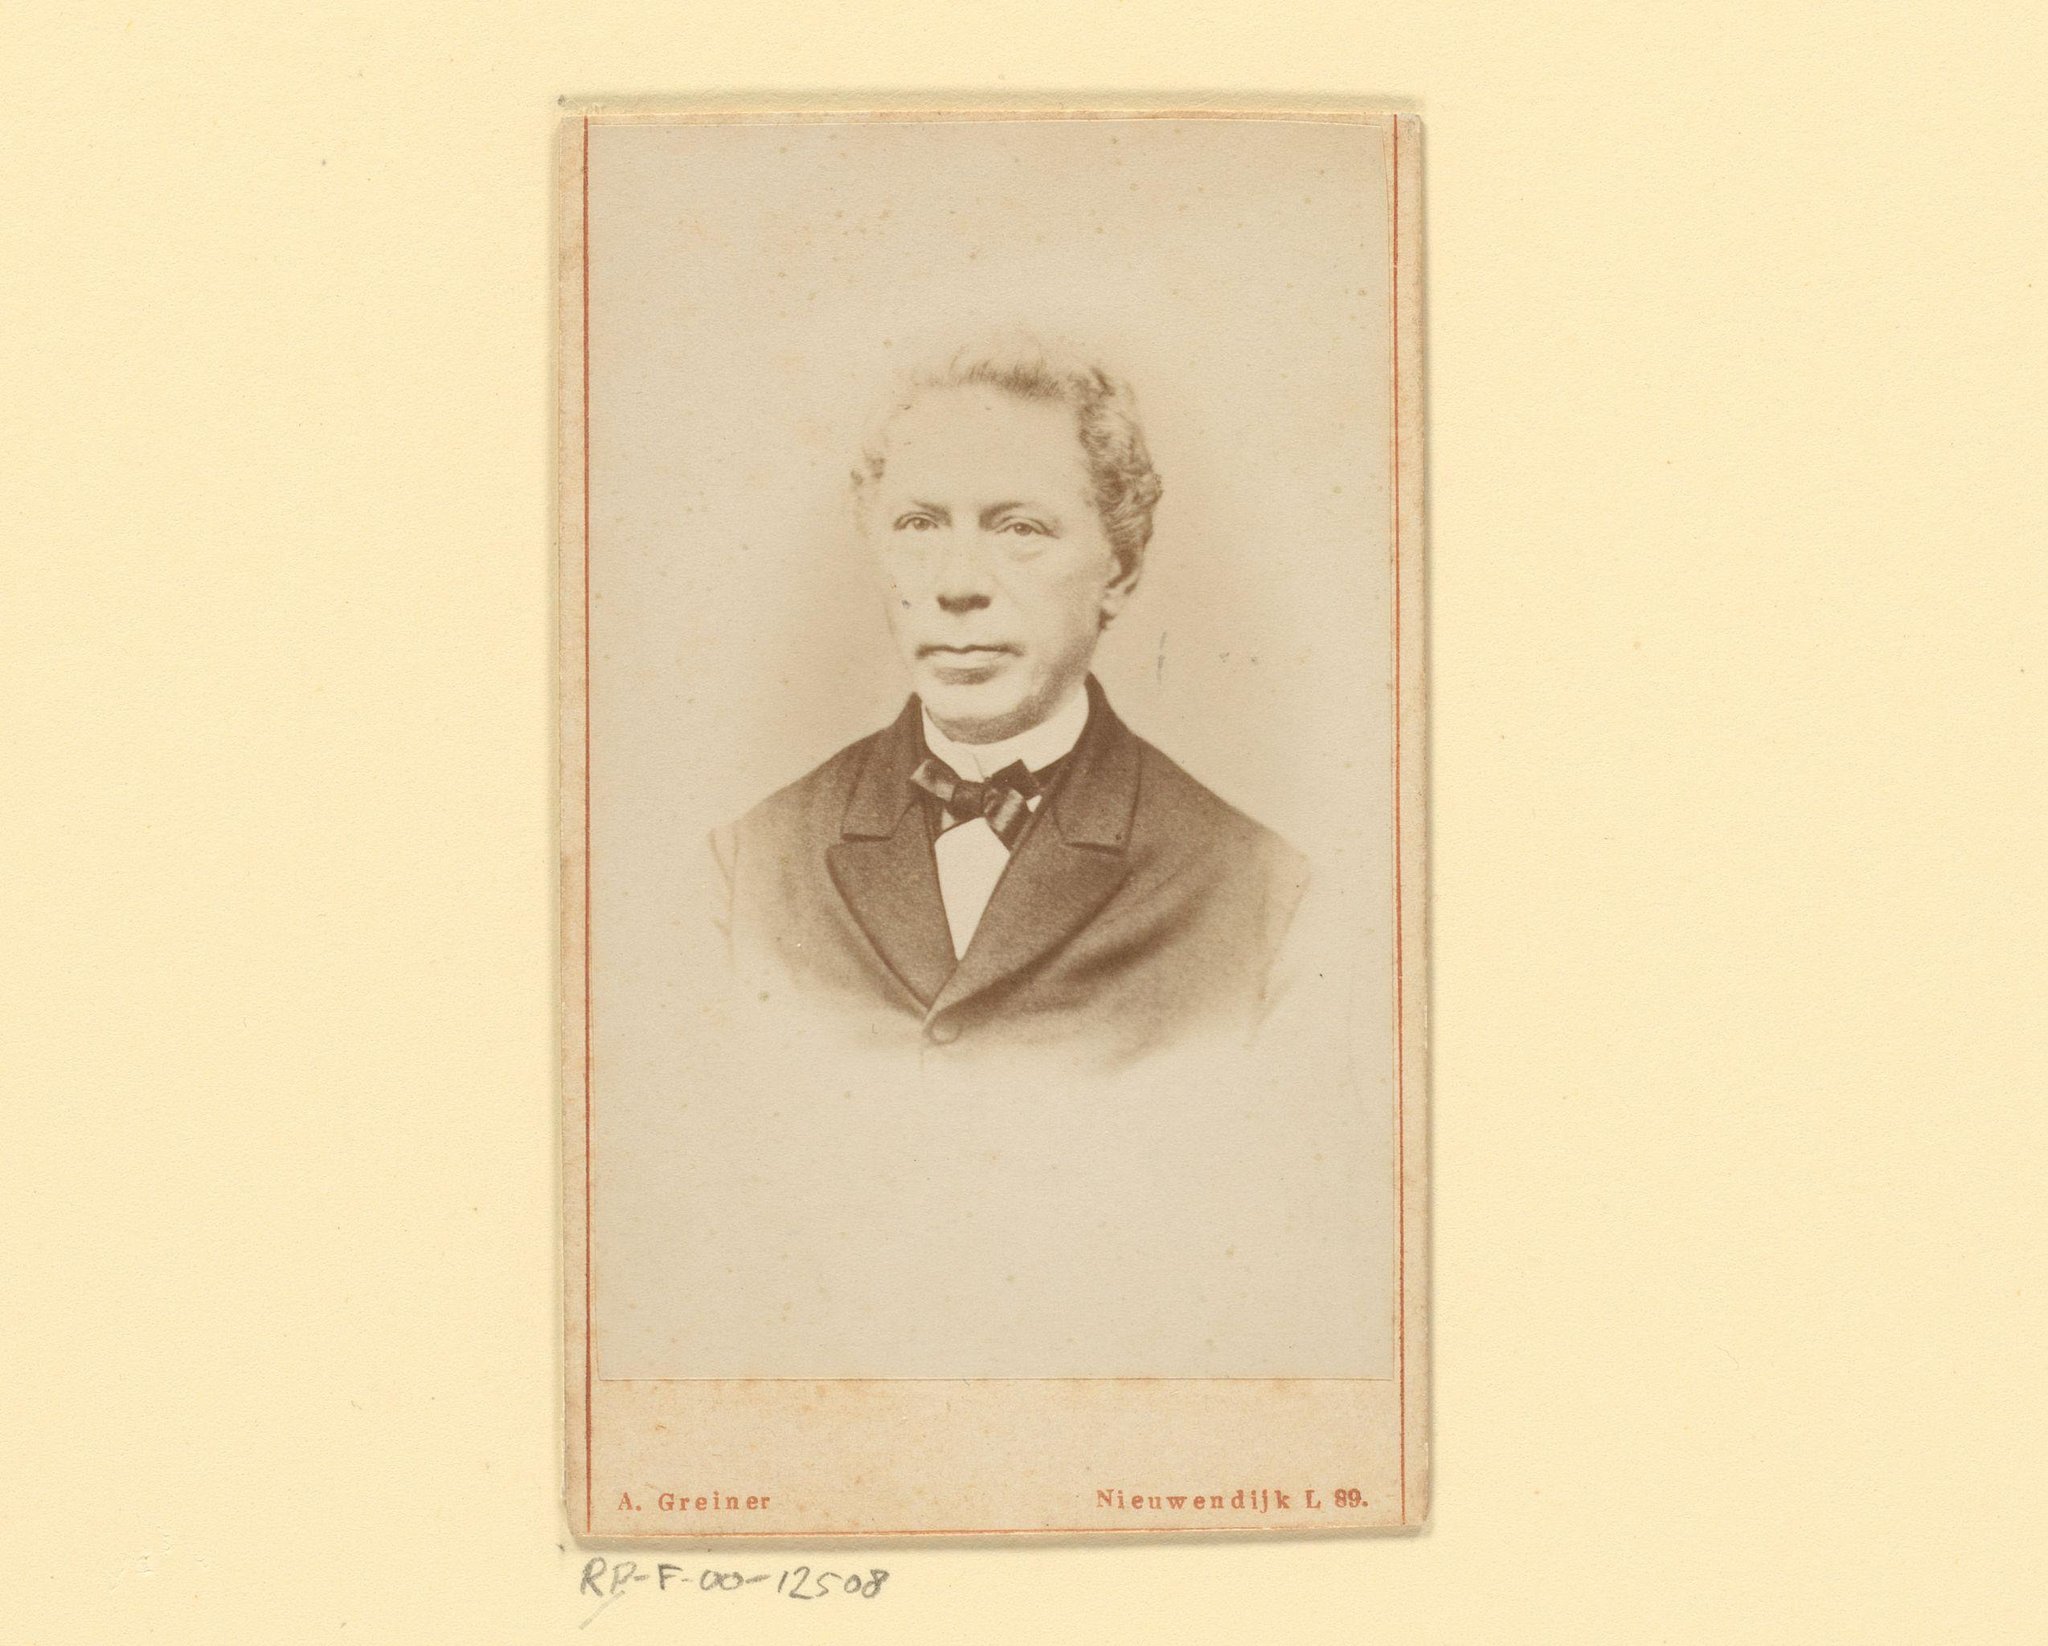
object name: carte de visite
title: Portret van Ambrosius Koot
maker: albert greiner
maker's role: fotograaf, fotostudio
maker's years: 1833-1890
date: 1874-1876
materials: cardboard, paper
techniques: albumen print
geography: amsterdam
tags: haarlem, painter, historical persons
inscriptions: address: ‘Nieuwendijk.L.89’, inscription: ‘Bijz. onderwijzer, eerst te/ Amsterdam, later te Haarlem/ Teekenaar en schilder.’